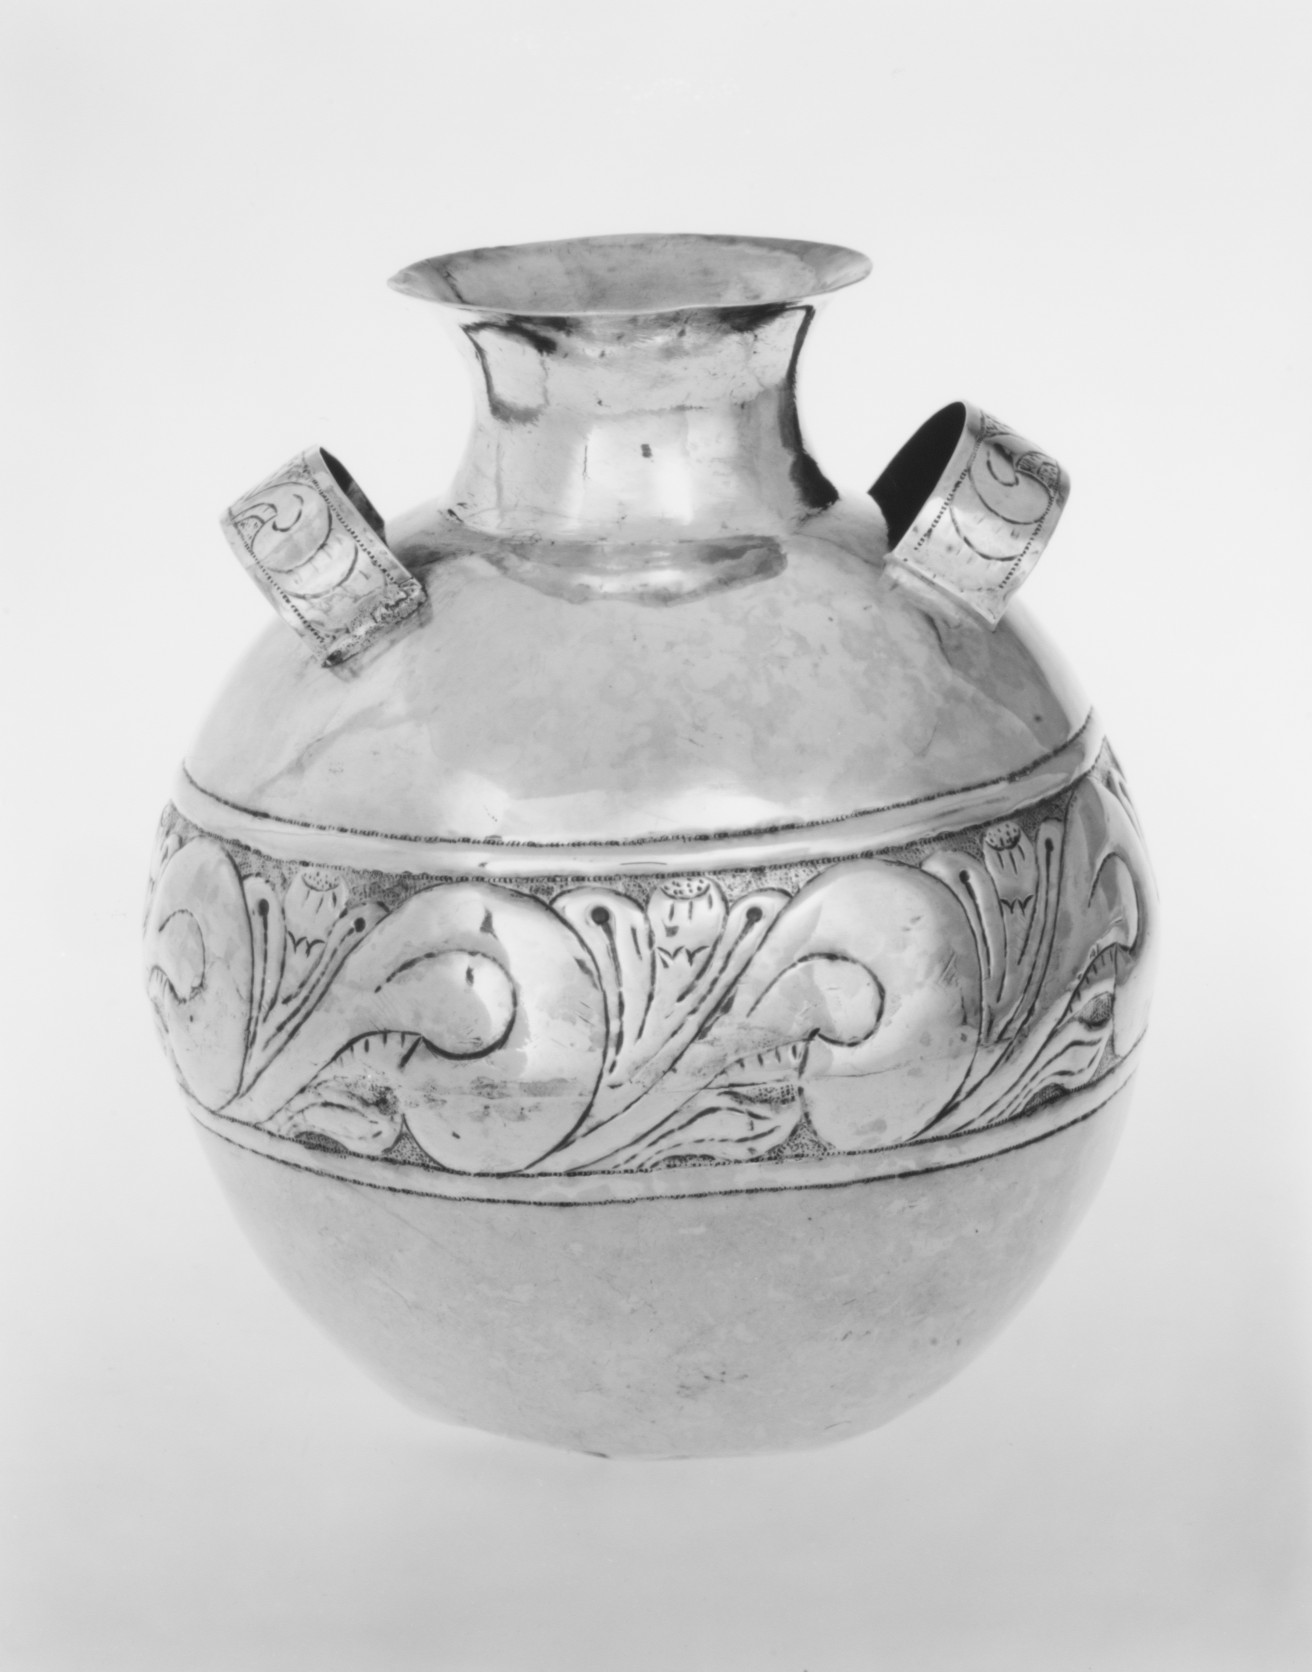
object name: pot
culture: south american, bolivian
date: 1701-1800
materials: silver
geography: bolivia